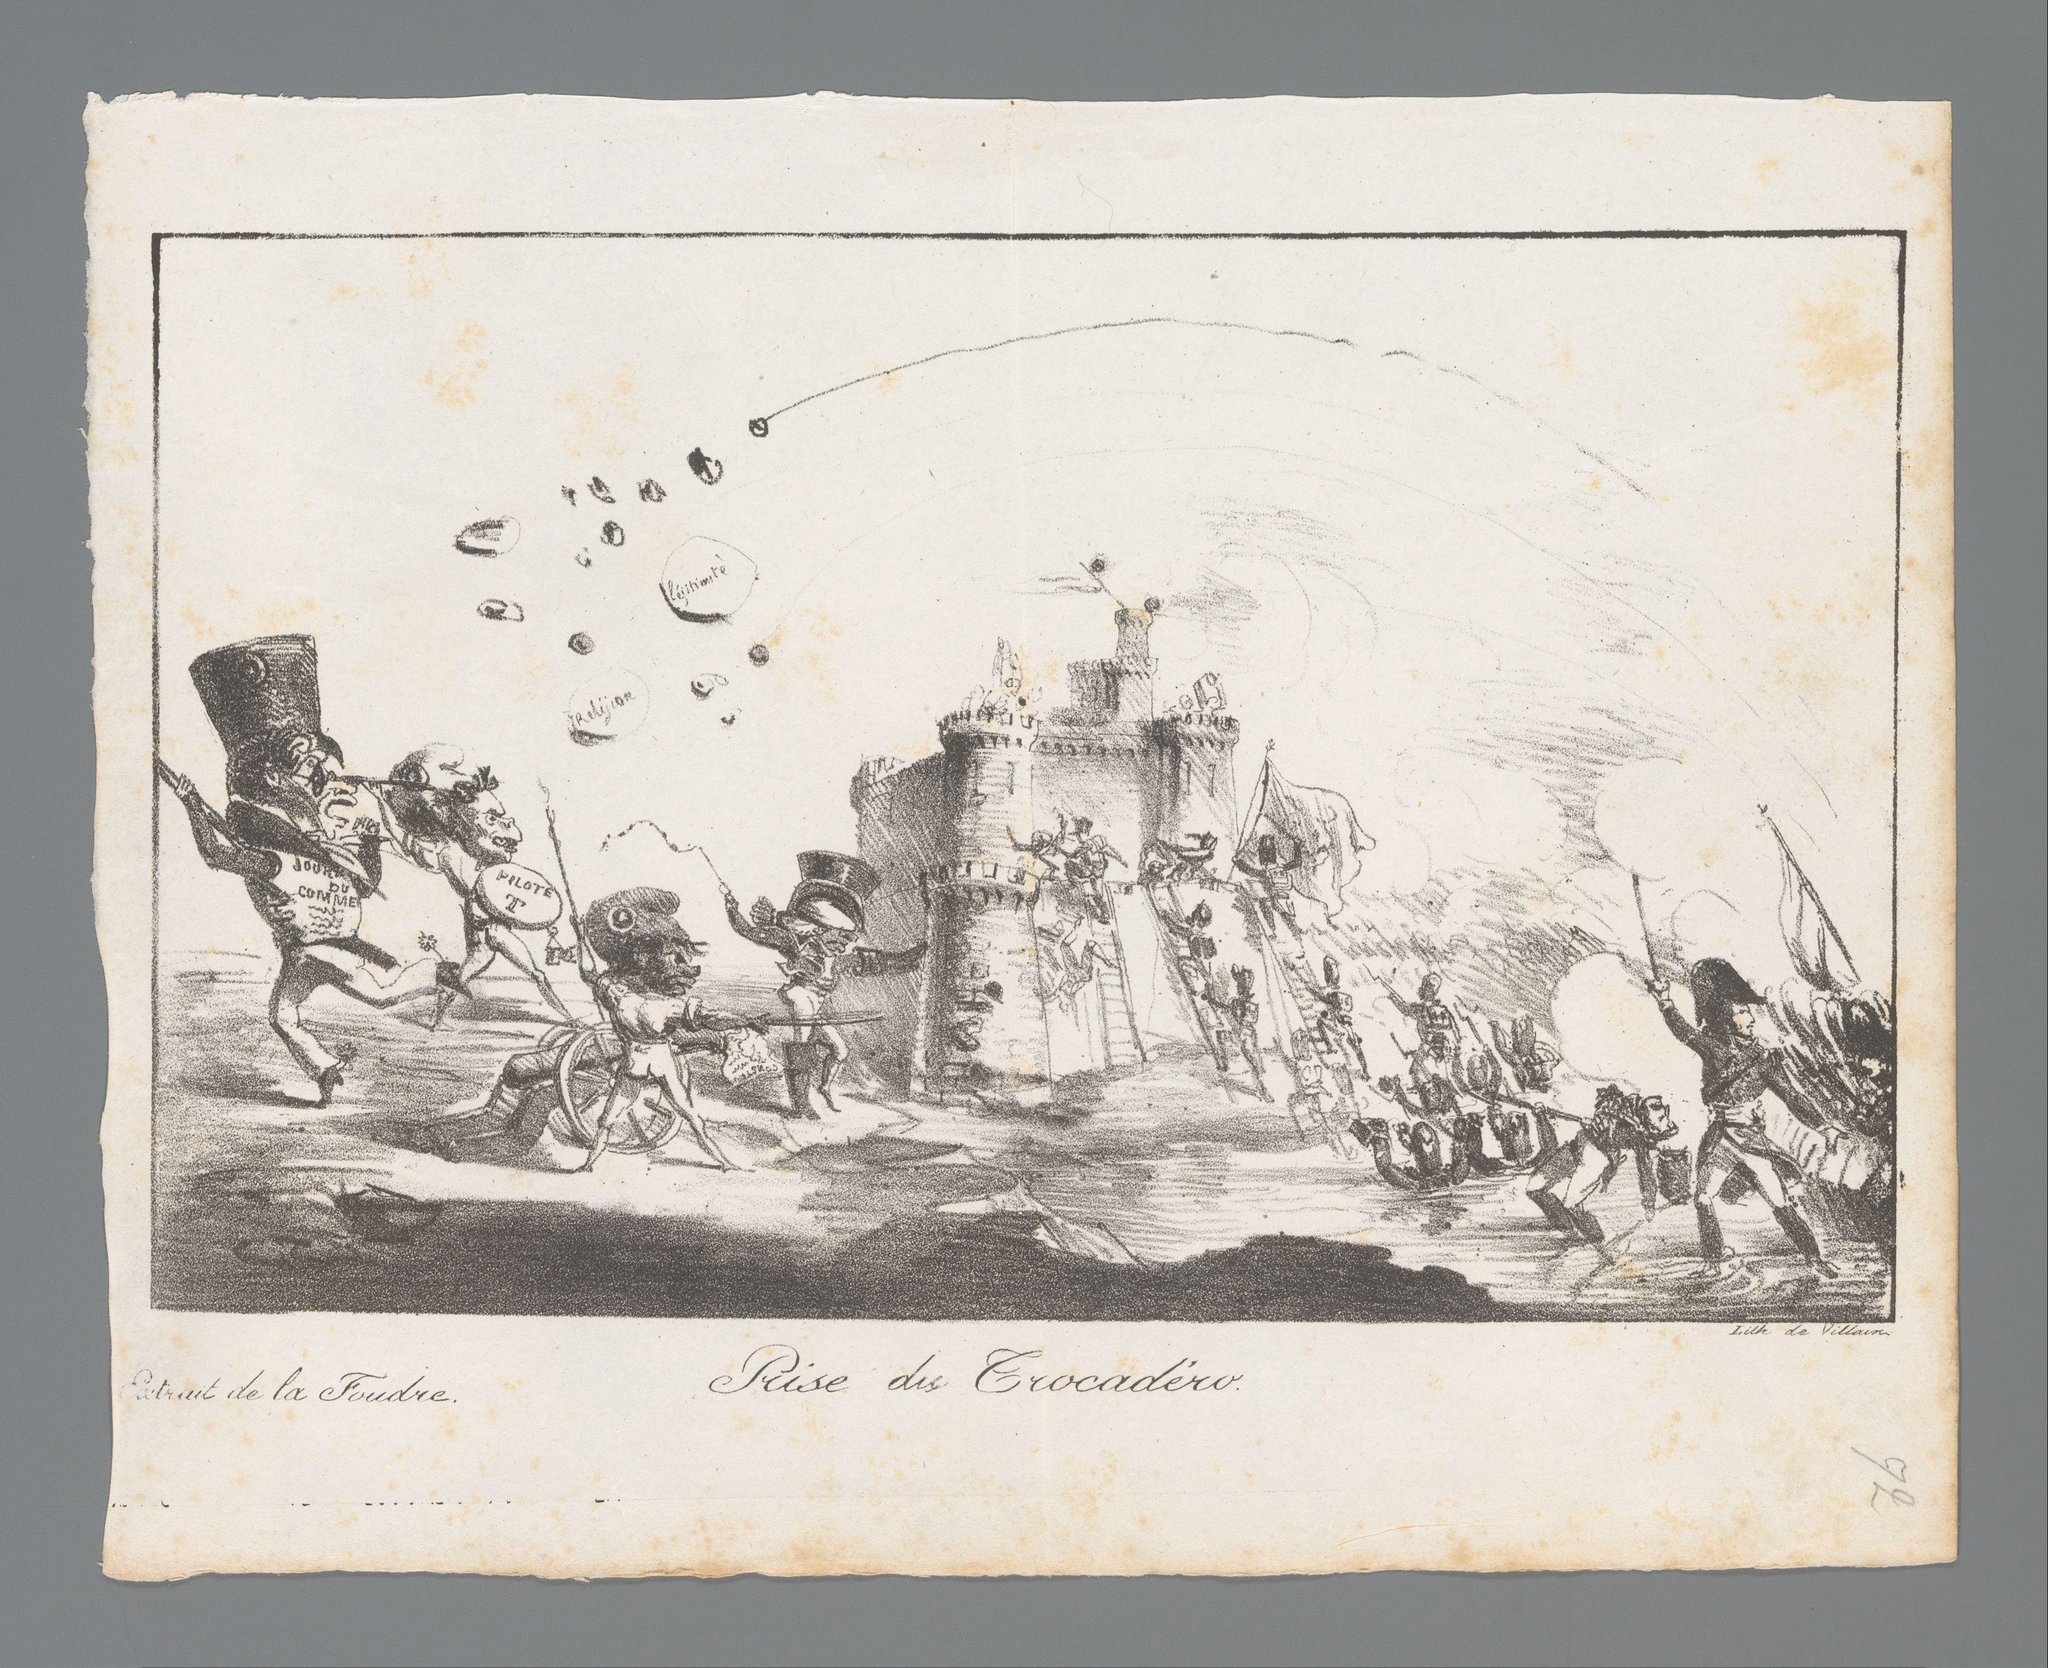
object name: print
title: Prise du Trocadéro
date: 1821-1823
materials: paper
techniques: lithograph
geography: paris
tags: castle, siege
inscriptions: collector's mark: Lugt 2228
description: Prent uit: La Foudre, journal de la littérature, des spectacles et des arts, 1821-1823.